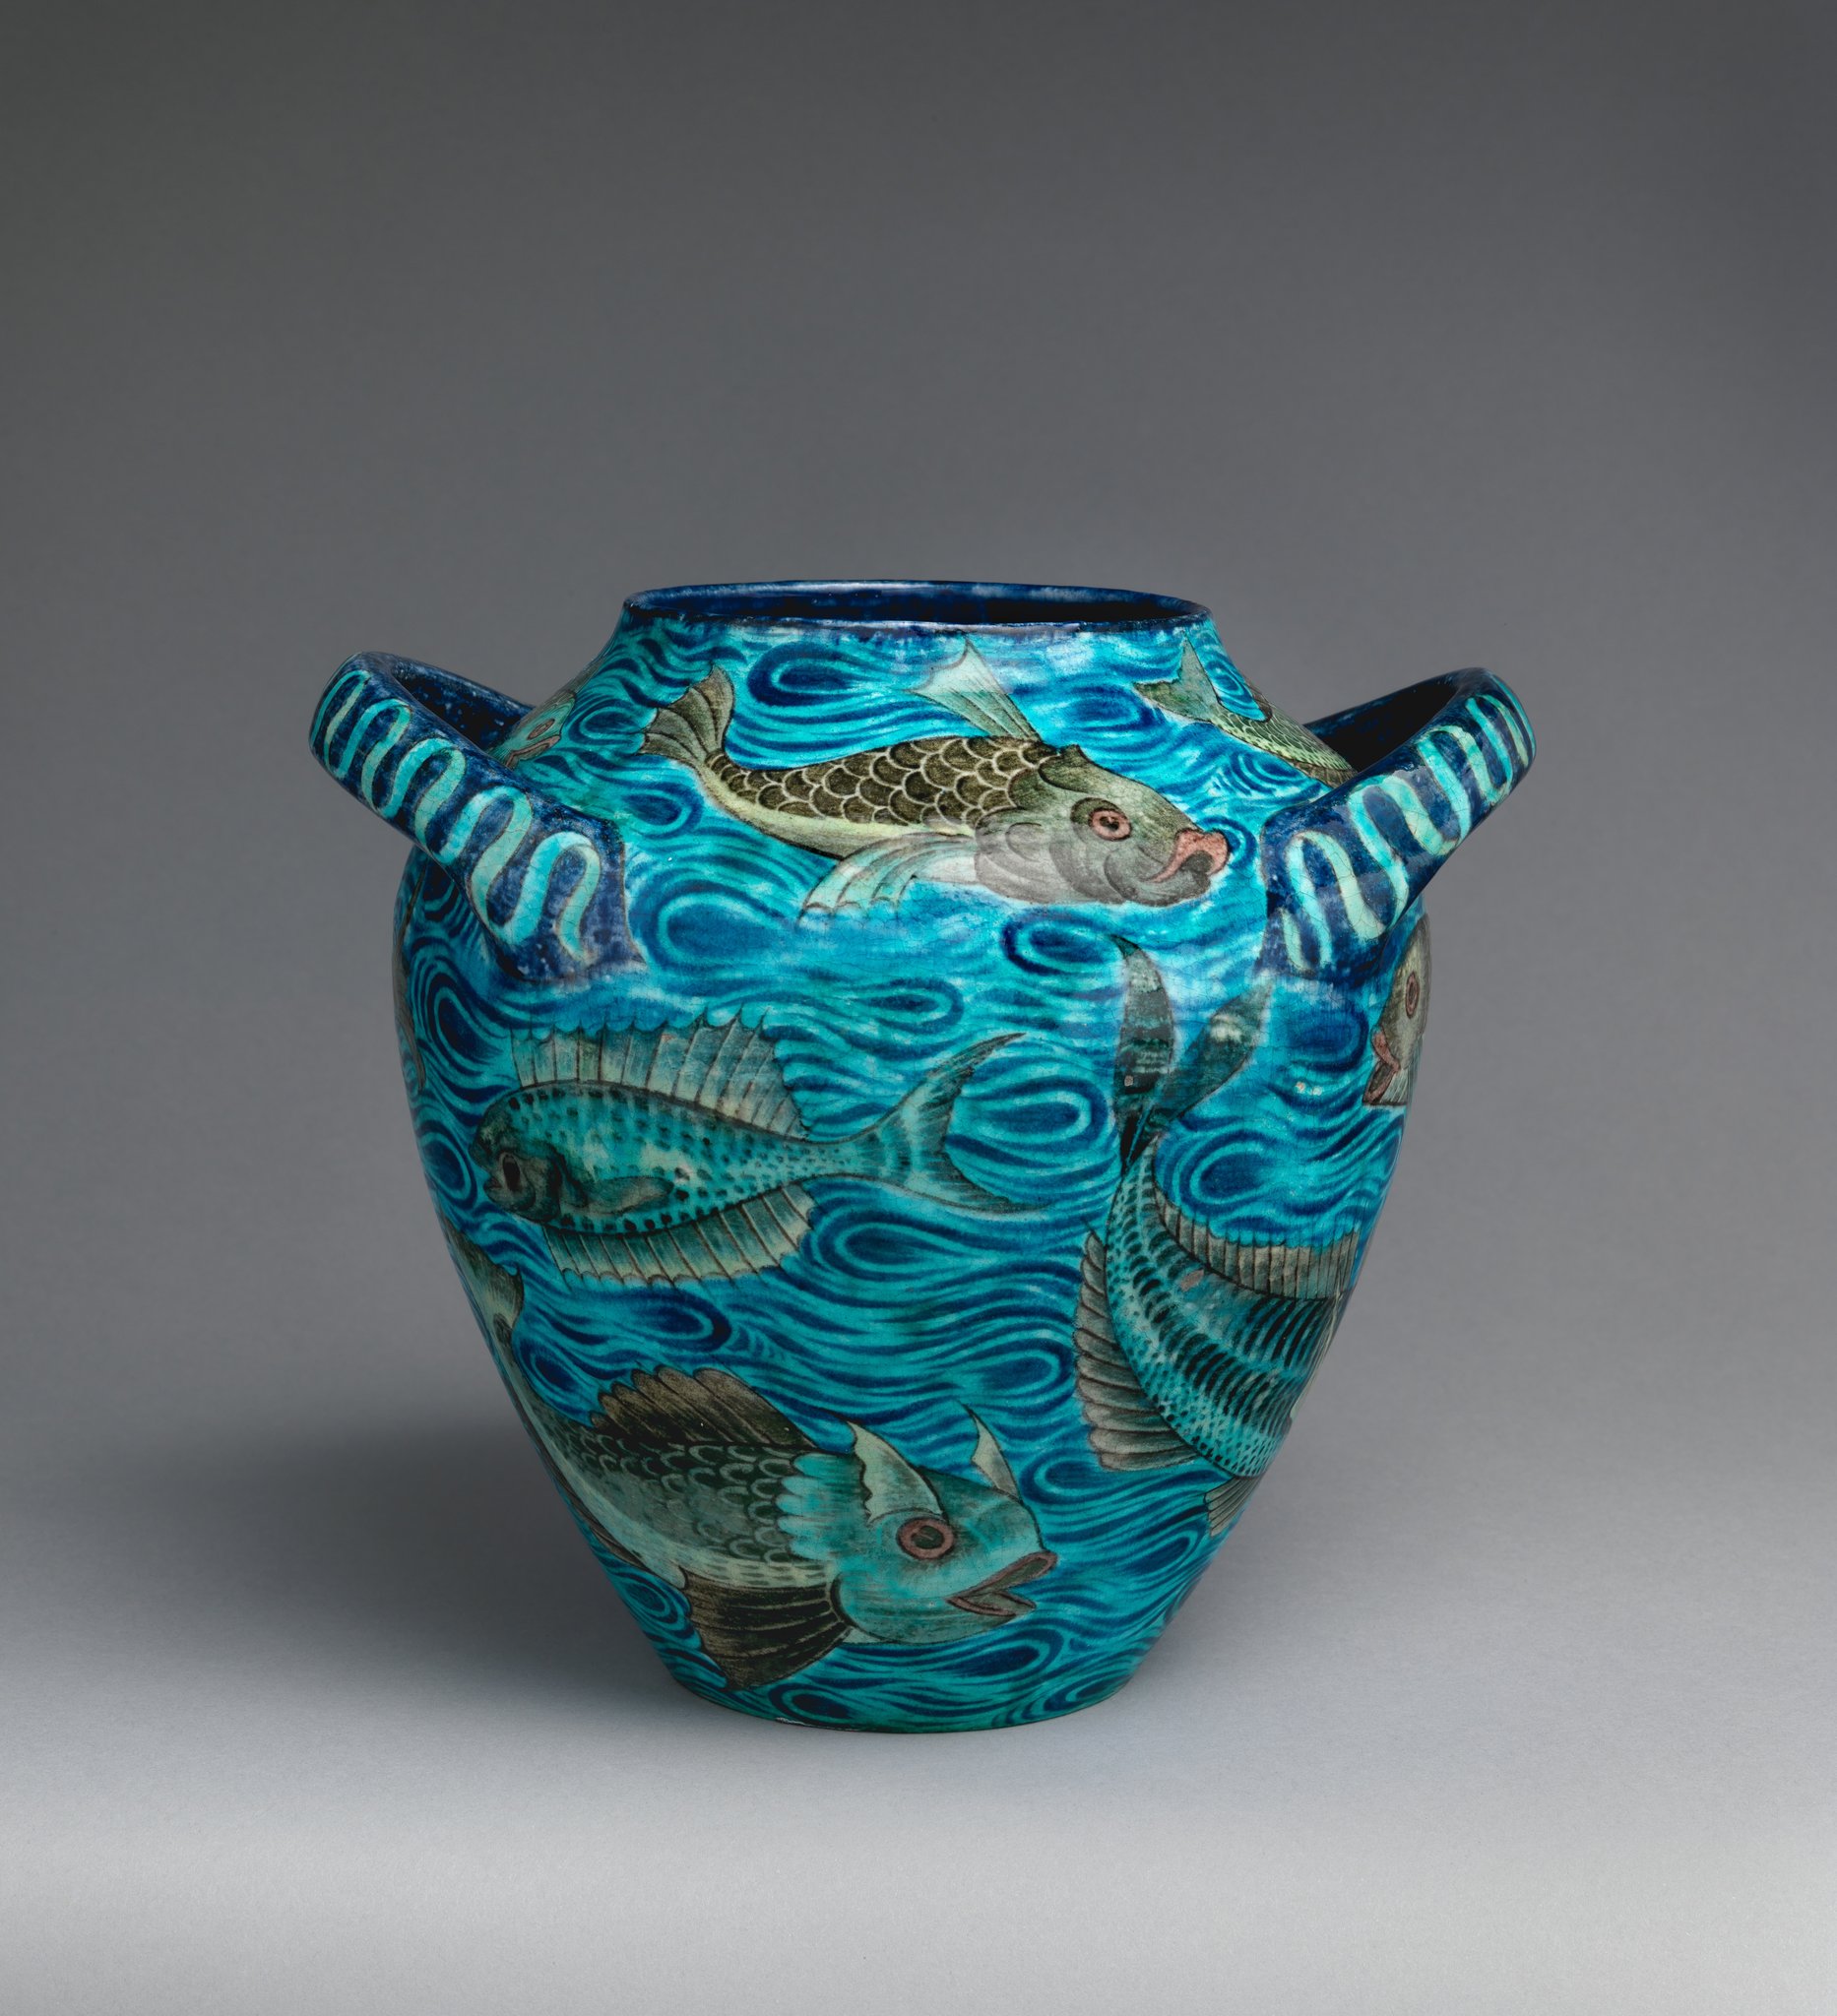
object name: vase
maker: william de morgan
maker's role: artist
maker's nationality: british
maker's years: 1839-1917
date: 1900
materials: earthenware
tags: fish